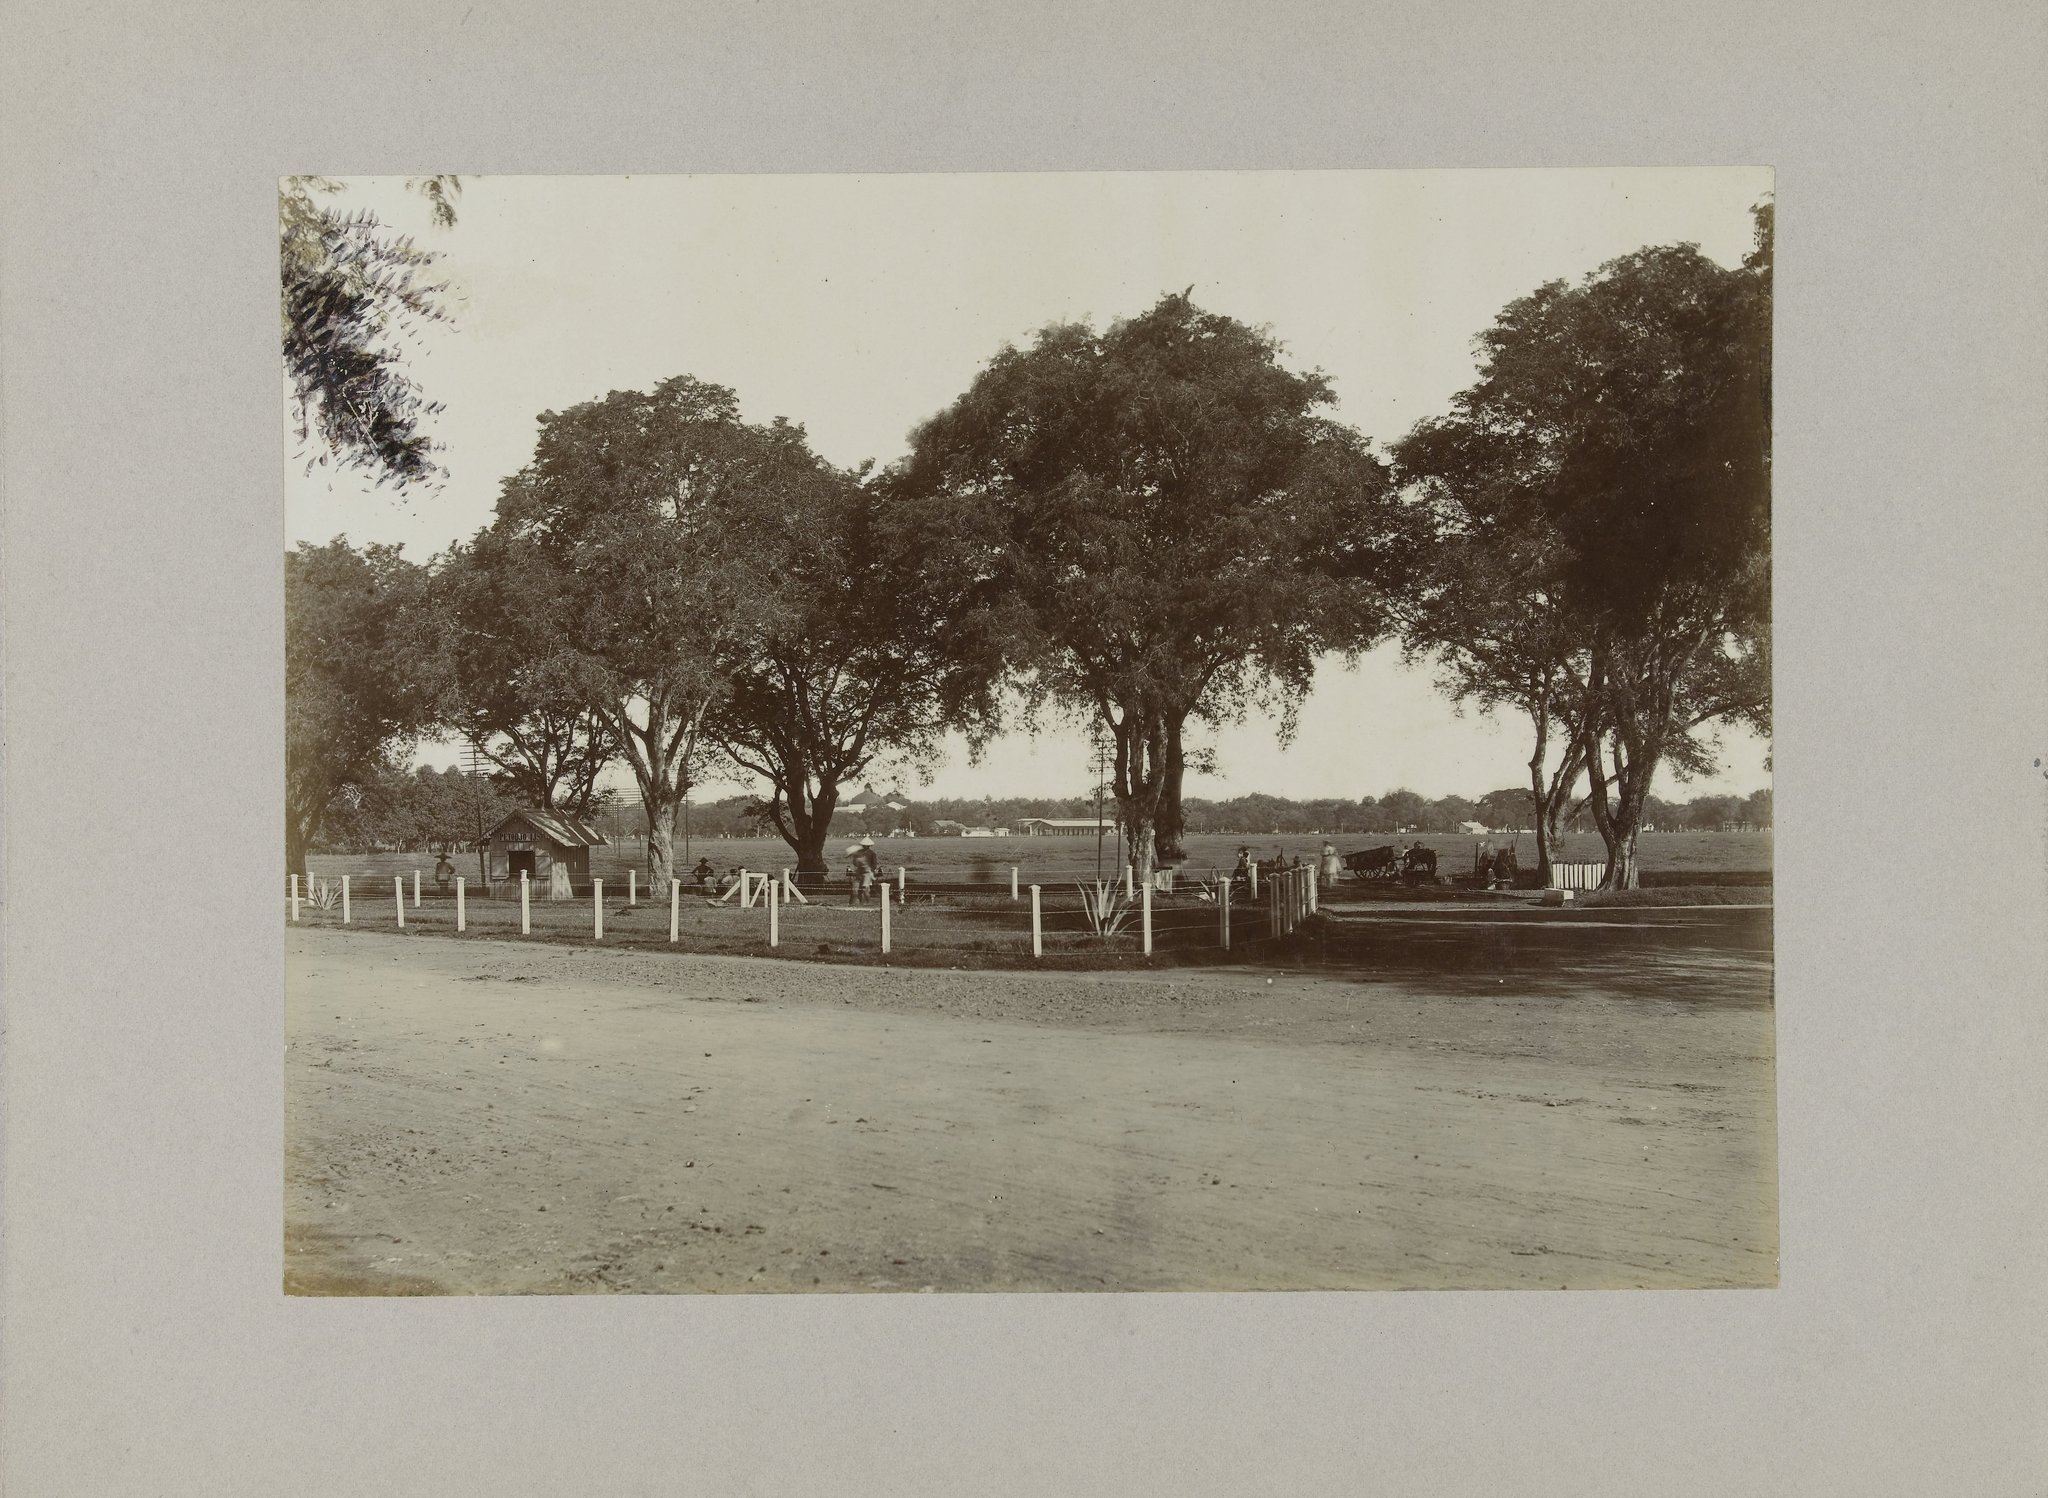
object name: photograph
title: 43. Koningsplein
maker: Anonymous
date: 1895-1915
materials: cardboard, paper, photographic support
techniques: gelatin silver print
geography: batavia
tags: indonesia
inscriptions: annotation: ‘43. Koningsplein’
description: Gezicht op het Koningsplein, Batavia (Jakarta), Java, Nederlands-Indië